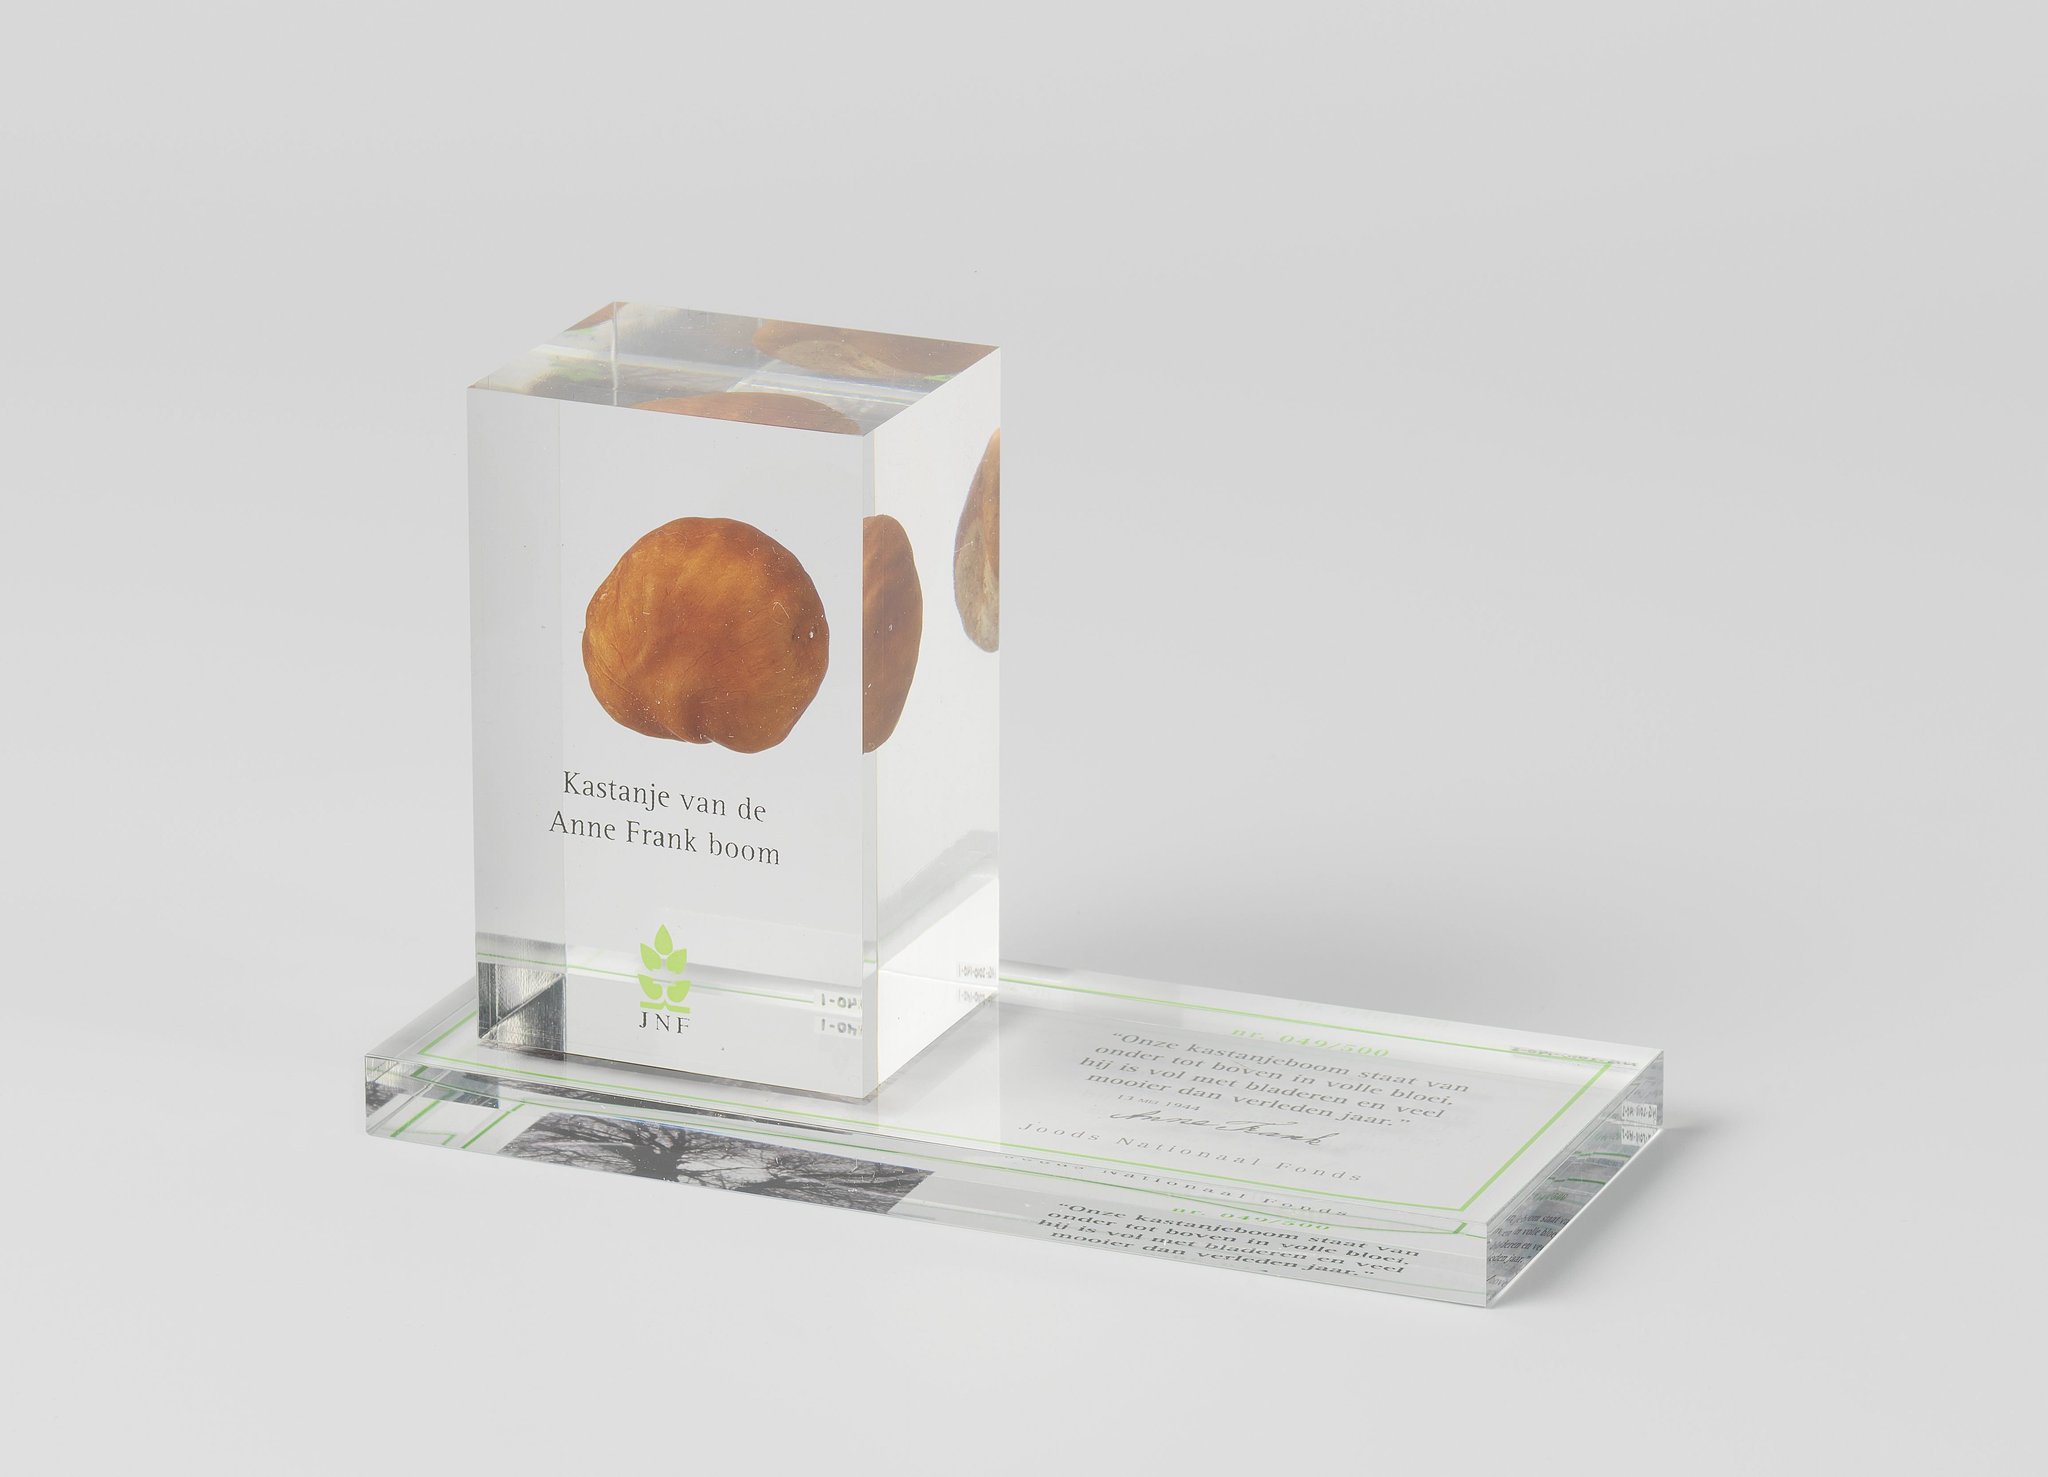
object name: commemorative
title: Echtheidsverklaring behorend bij kastanje Anne Frank boom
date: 2010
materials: paper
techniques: printing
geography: netherlands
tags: anne frank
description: Papieren echtheidsverklaring behorend bij kastanje Anne Frankboom, uitgegeven door het Joods Nationaal Fonds, waarin voor de echtheid van de kastanje wordt ingestaan en wordt uitgelegd wat het Joods Nationaal Fonds doet met donaties. Tevens een gedrukte afbeelding van het object.